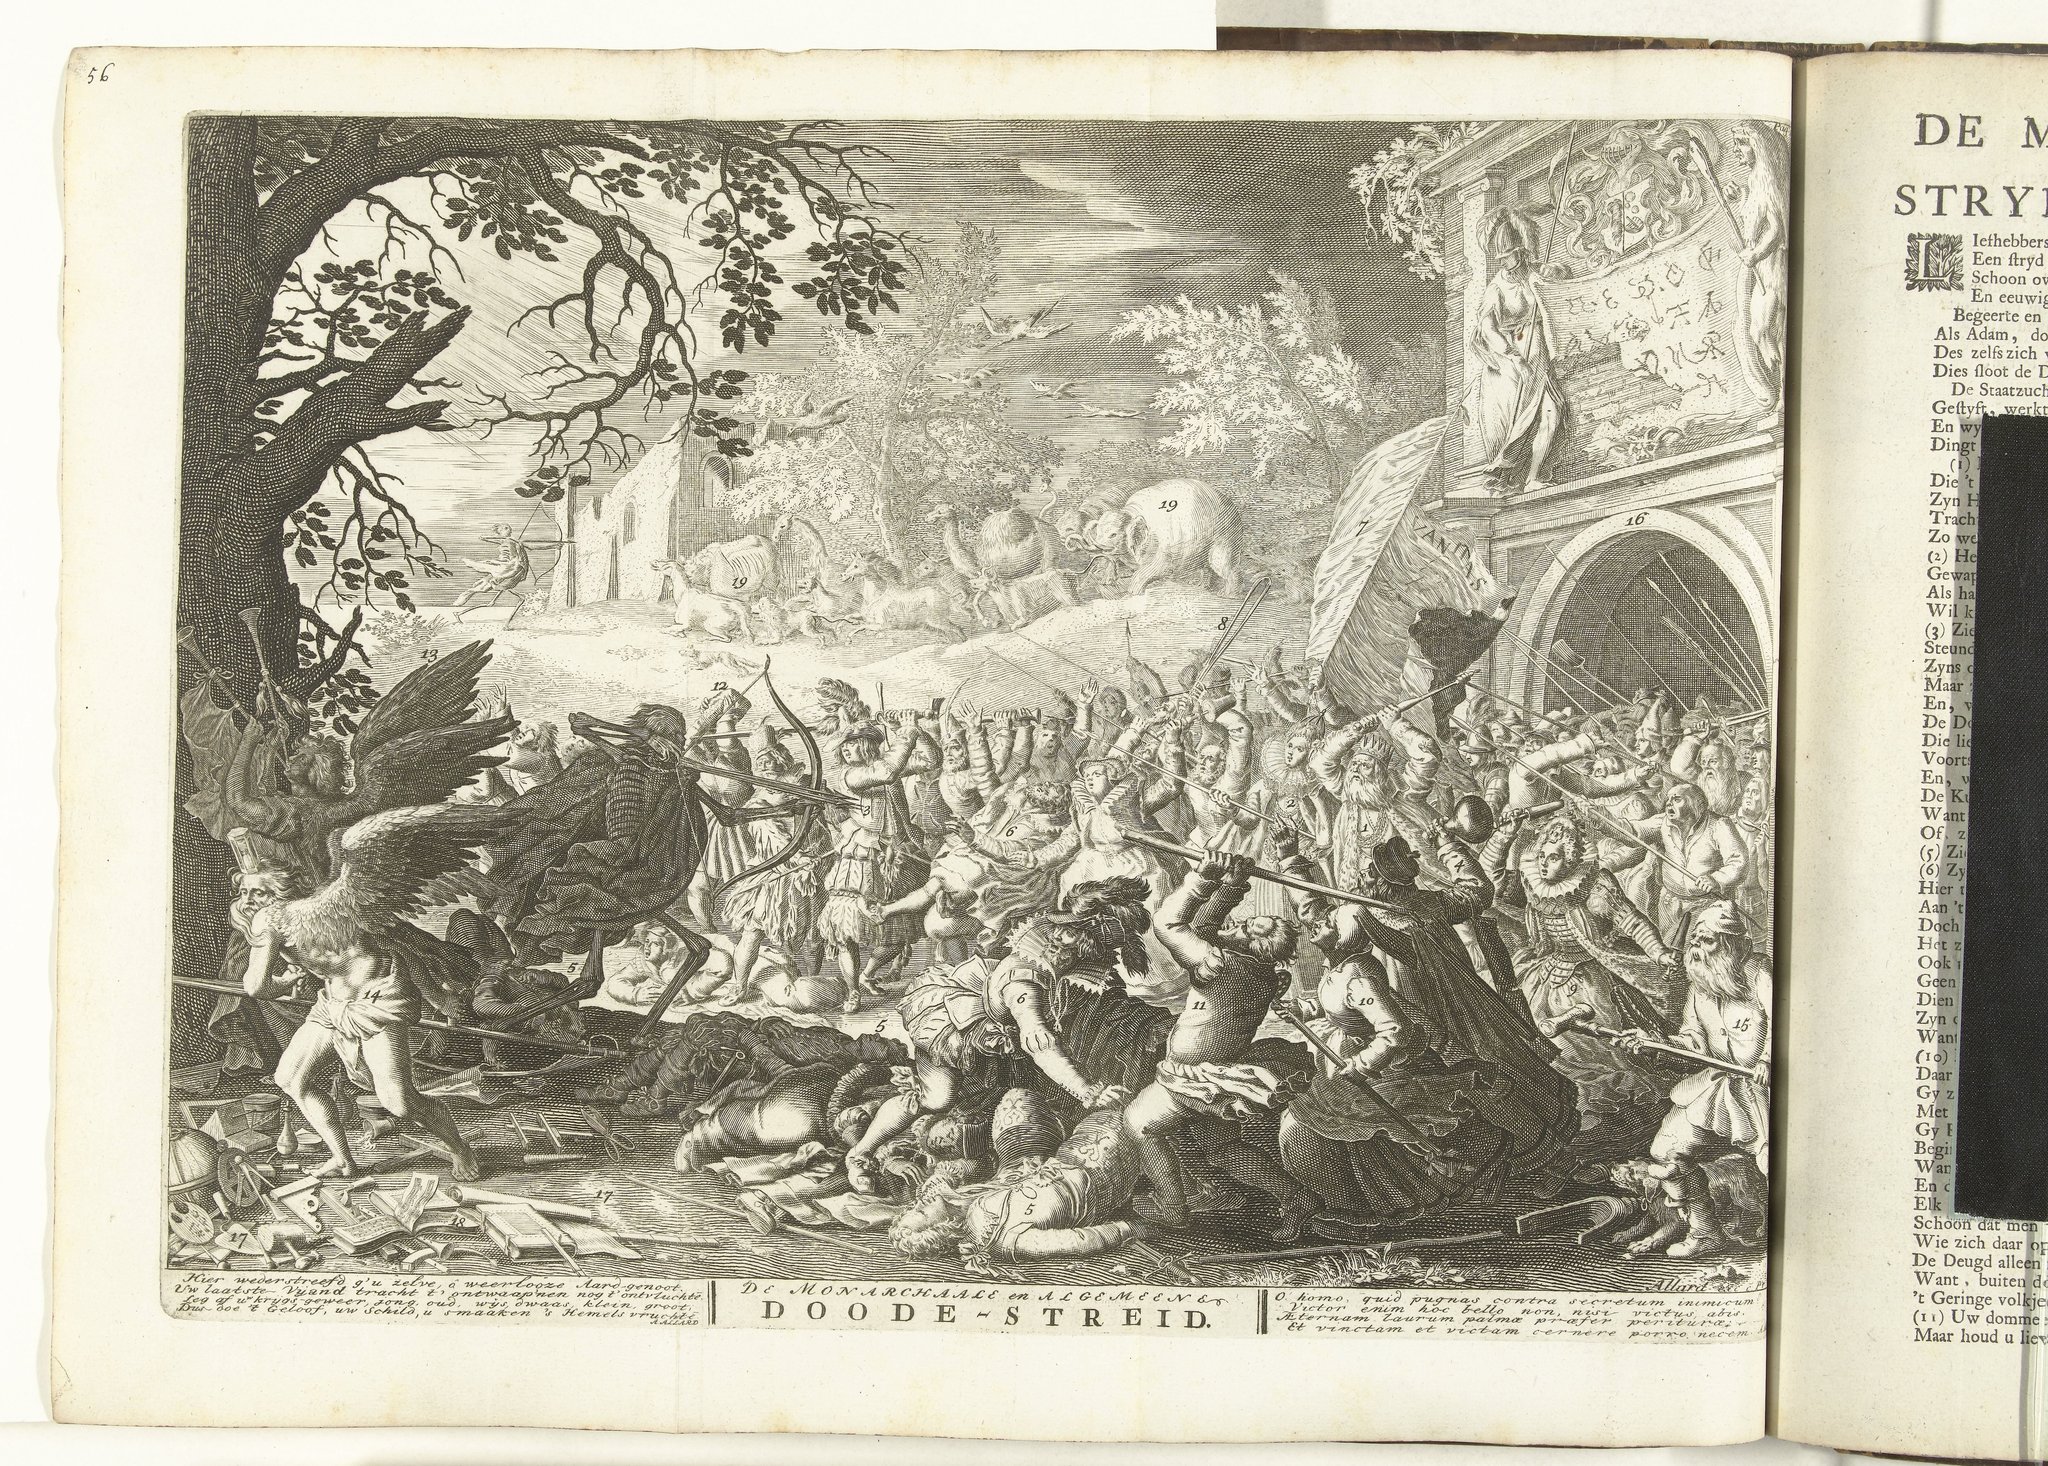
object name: print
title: Dood vecht tegen de mensheid, ca. 1707-1708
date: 1610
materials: paper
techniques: engraving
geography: low countries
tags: death battling with life, or with the living, fame; 'fama', 'fama buona', 'fama chiara' (ripa), father time, man with wings and scythe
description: Allegorische voorstelling. De dood schiet zijn pijlen af op een gewapende menigte jonge en oude, arme en rijke mannen en vrouwen die uit een poort komen stormen, ca. 1707-1708. Genummerd: 8 en gemerkt: Pag. 19. Onderdeel van: De Standvastige Monarchye des Doods, een reeks van 8 oude platen met verzen aangepast voor gebruik als spotprenten op de Fransen in de context van de Spaanse Successieoorlog. Onderdeel van het prentwerk uitgegeven onder de verzameltitel 't Lust-Hof van Momus met de gebundelde series van spotprenten tijdens de jaren 1701-1713 van de Spaanse Successieoorlog.